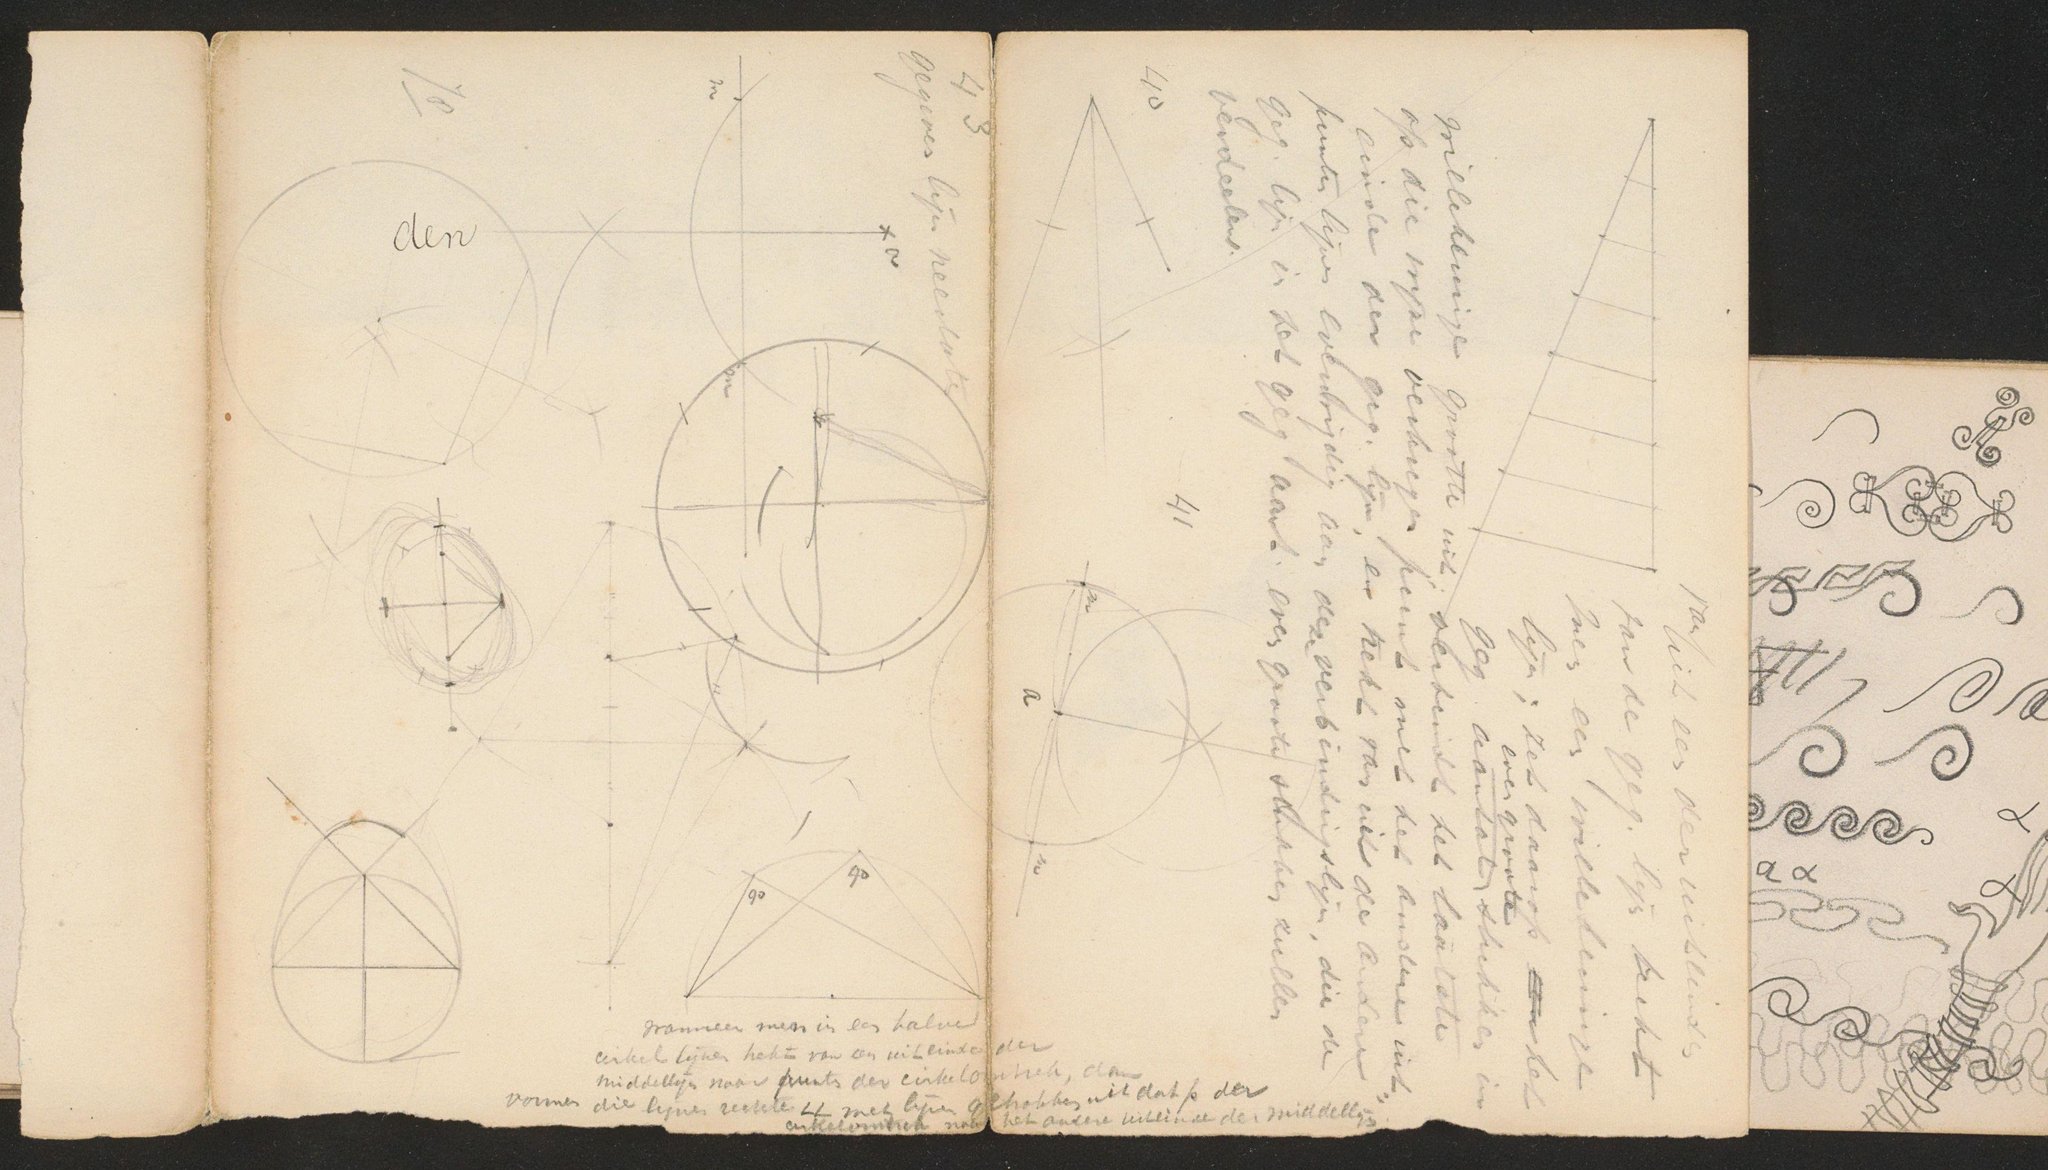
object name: sketchbook leaf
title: Geometrische figuren en lijnen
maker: julie de graag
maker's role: draughtsman, print maker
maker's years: 1877-1924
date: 1894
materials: paper, pencil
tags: triangle (~ planimetry, geometry), straight line, circle (~ planimetry, geometry)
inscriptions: annotation: ‘[...]’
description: Verso-zijde van een losse tekening tussen pagina 35 en 34 van een schetsboek met 35 bladen.